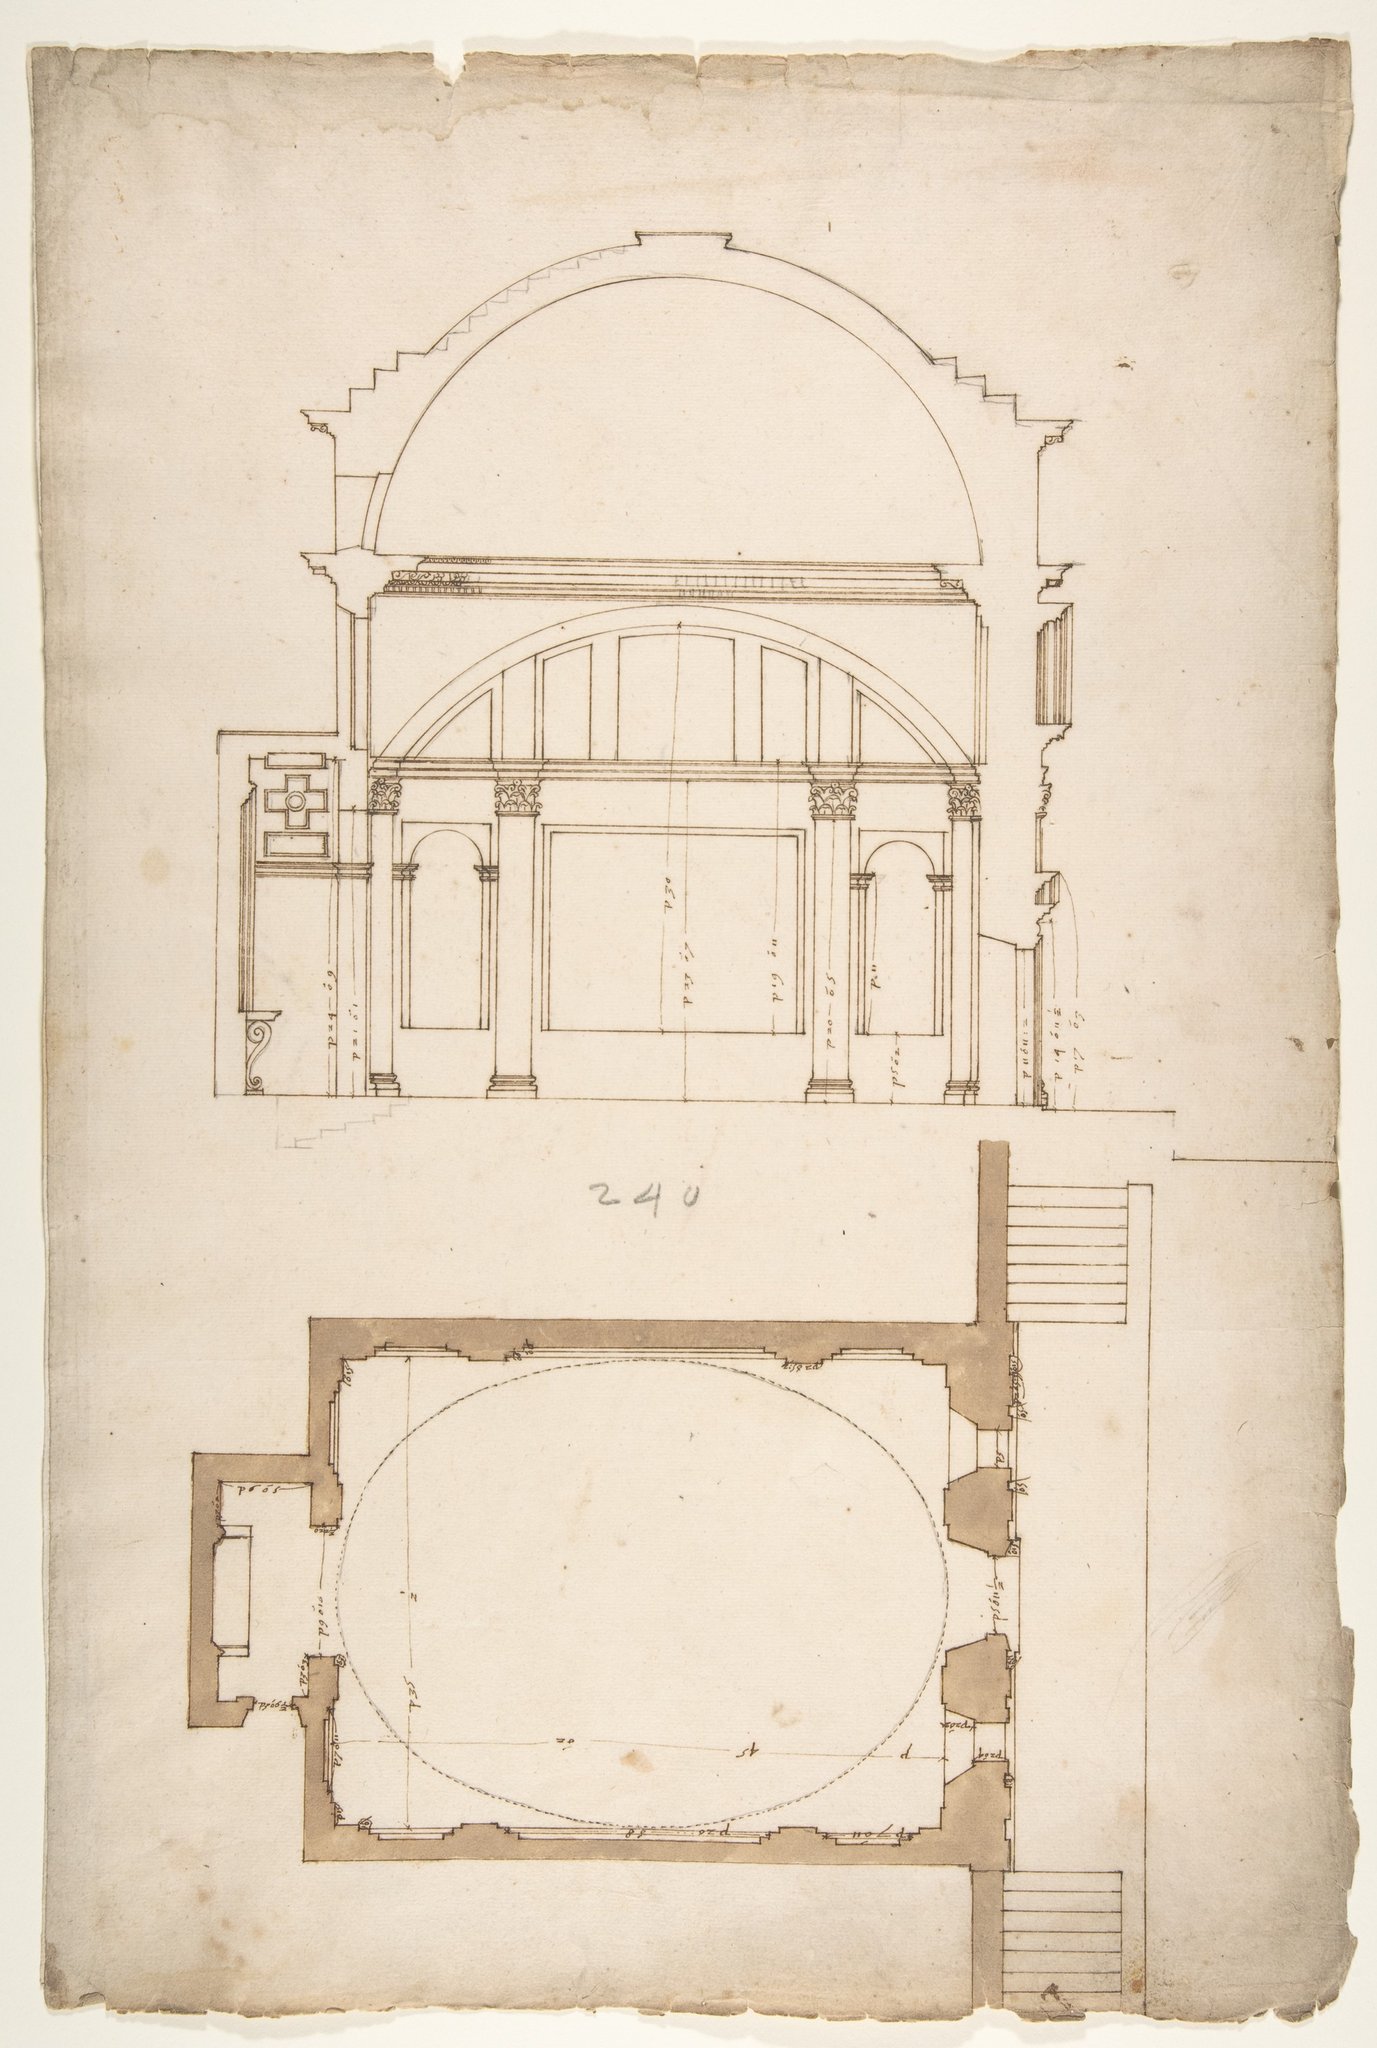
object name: drawing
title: S. Andrea via Flaminia, plan; section (recto) blank (verso)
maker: anonymous, french, 16th century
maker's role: draftsman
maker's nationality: french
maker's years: 1500-1600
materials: chalk, ink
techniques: incising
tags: architecture